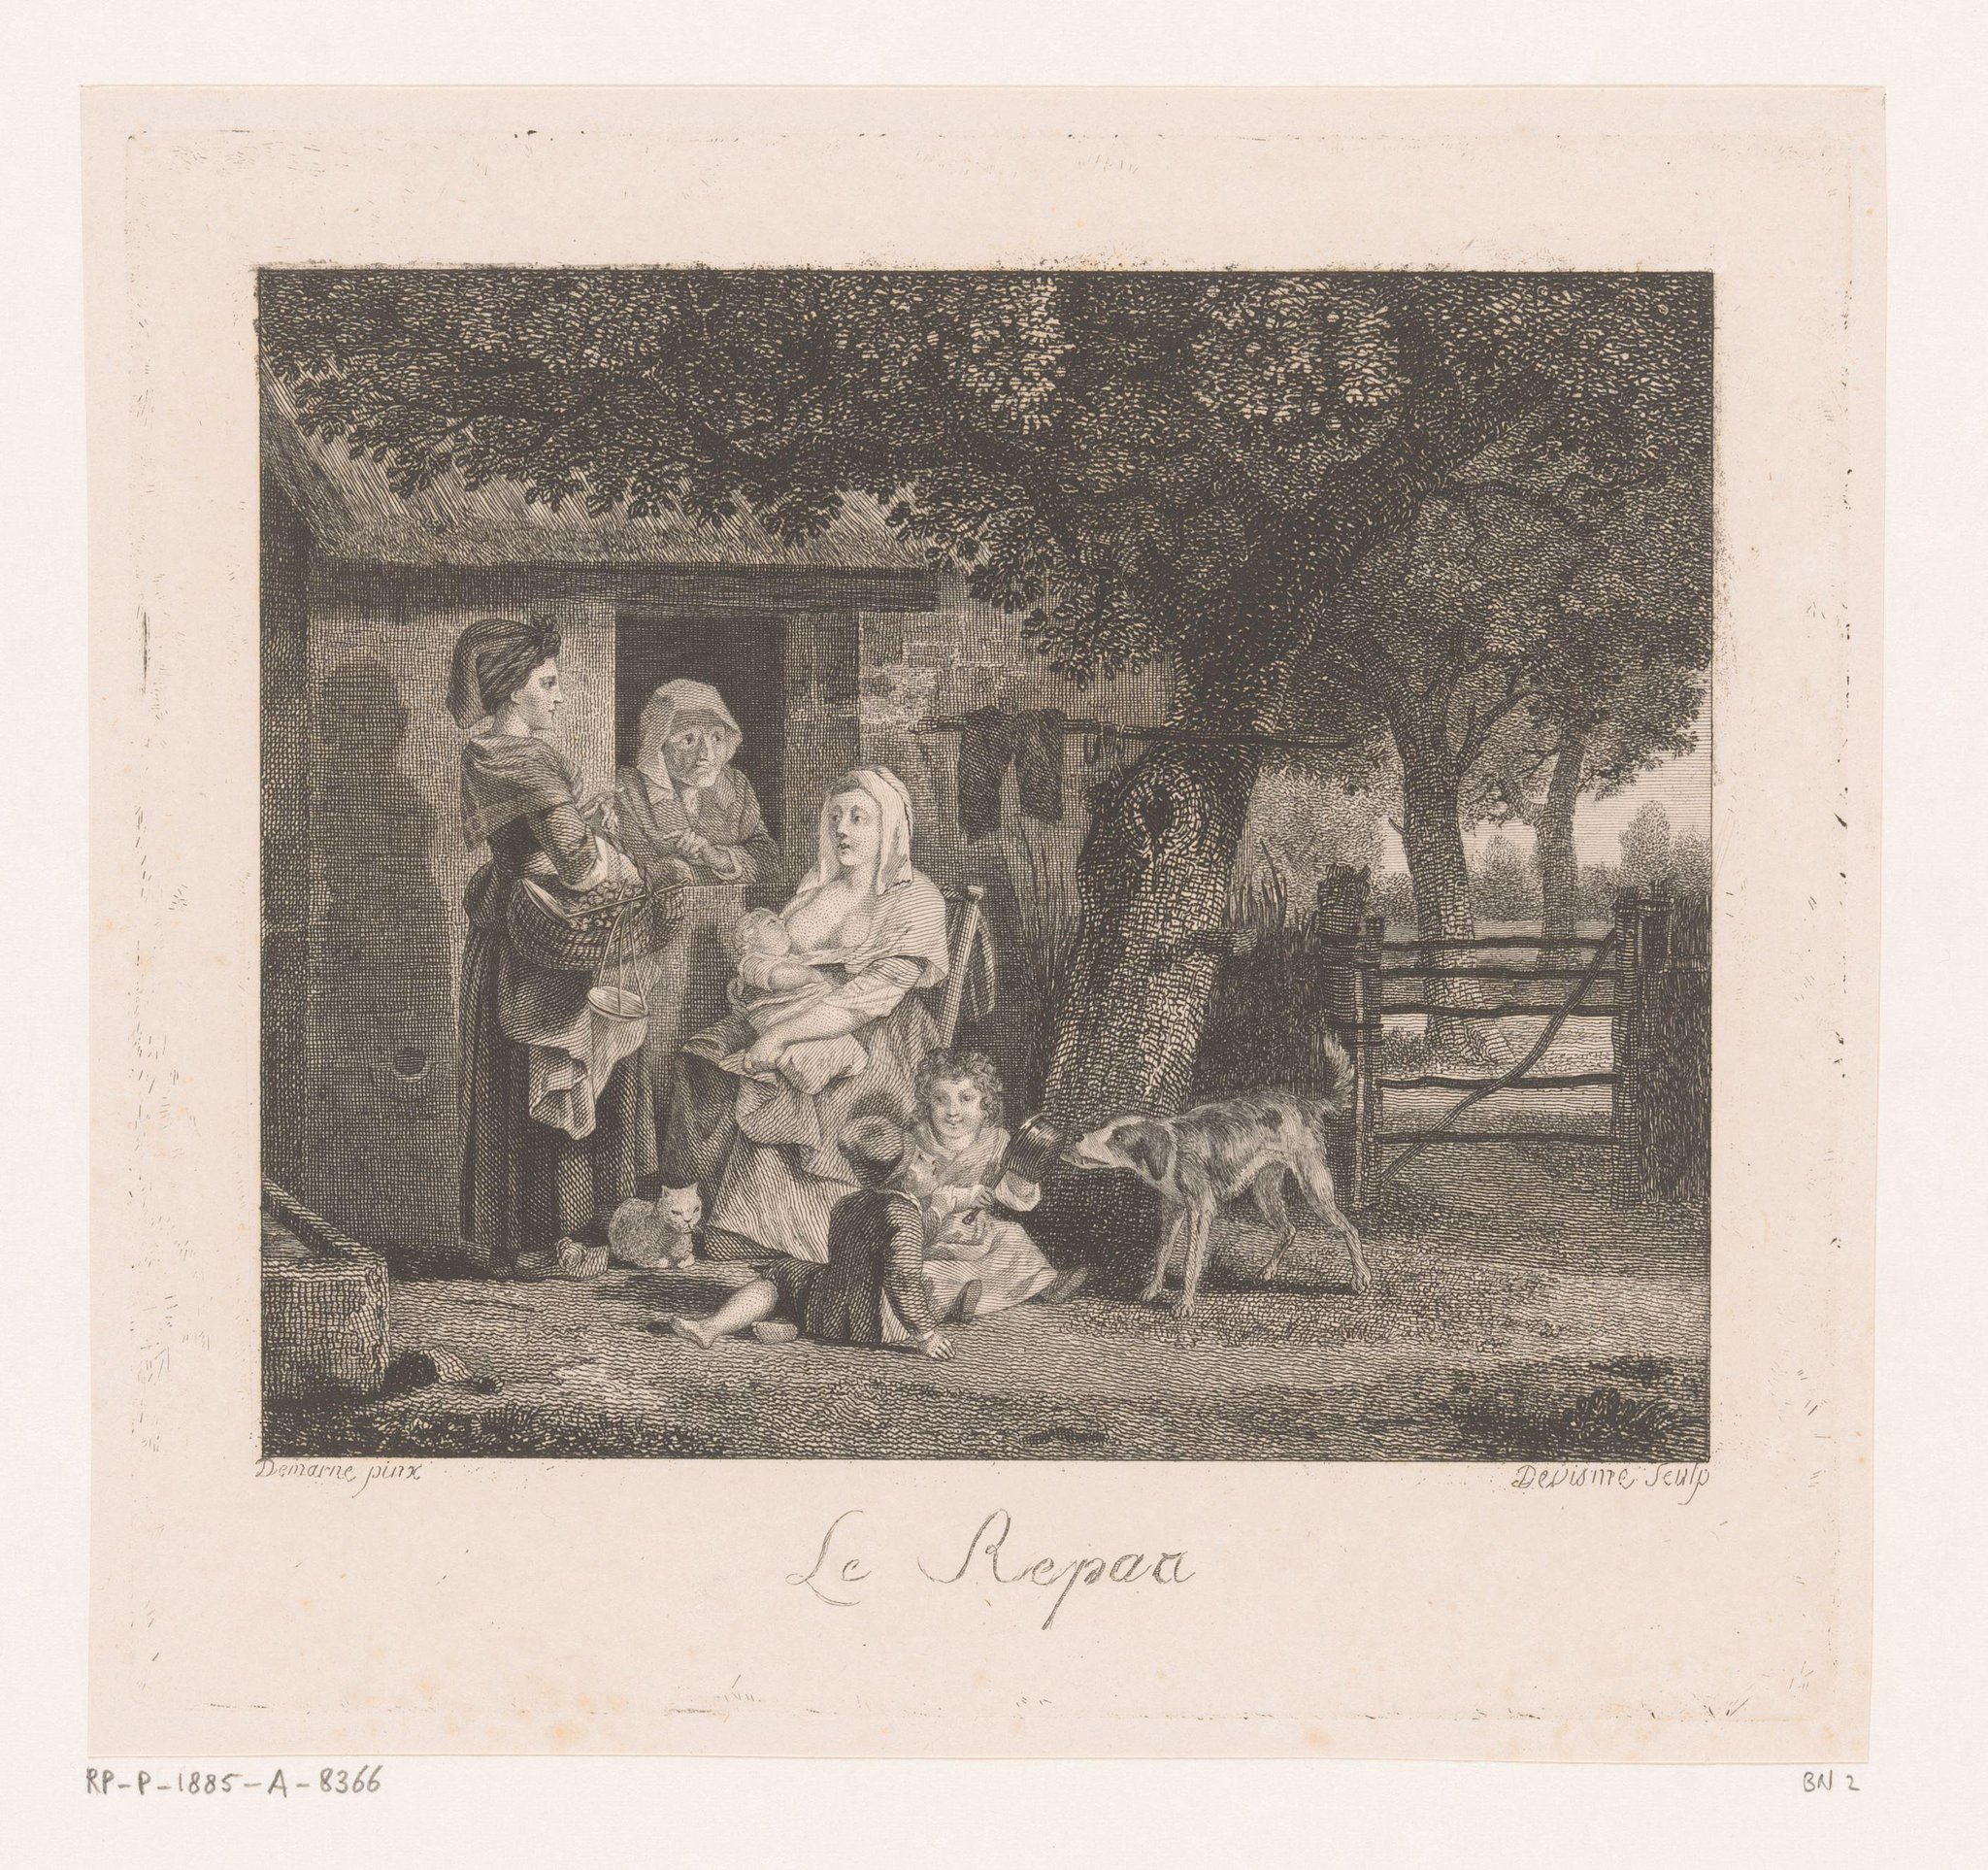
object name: print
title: Groep vrouwen met kinderen bij een huis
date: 1806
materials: paper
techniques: engraving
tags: feeding a baby, farm (building), resting - bb - out of doors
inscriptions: collector's mark: Lugt 2228